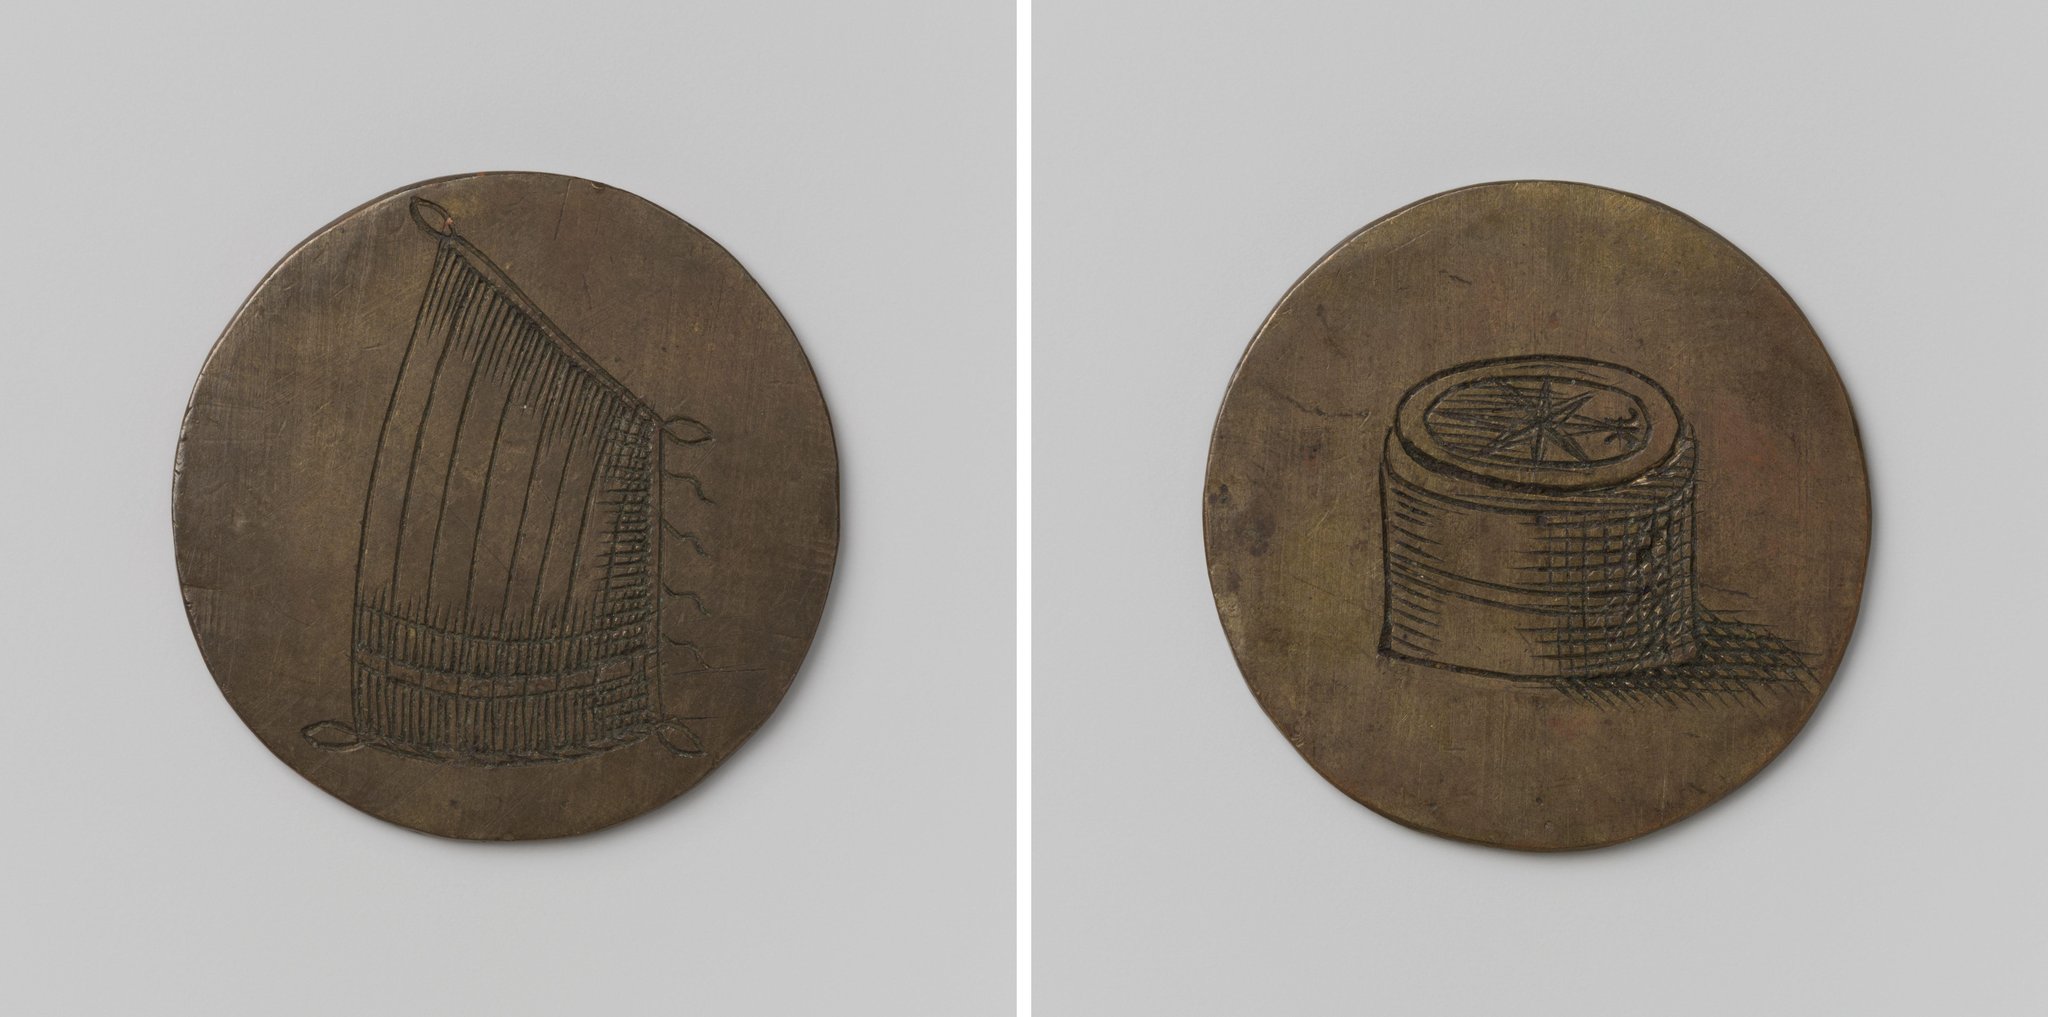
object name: medal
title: Kompas- en zeilmakersgilde van Amsterdam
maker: Anonymous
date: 1740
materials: brass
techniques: engraving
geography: amsterdam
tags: amsterdam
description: Messing penning, v.z:zeil. Keerzijde:kompas.